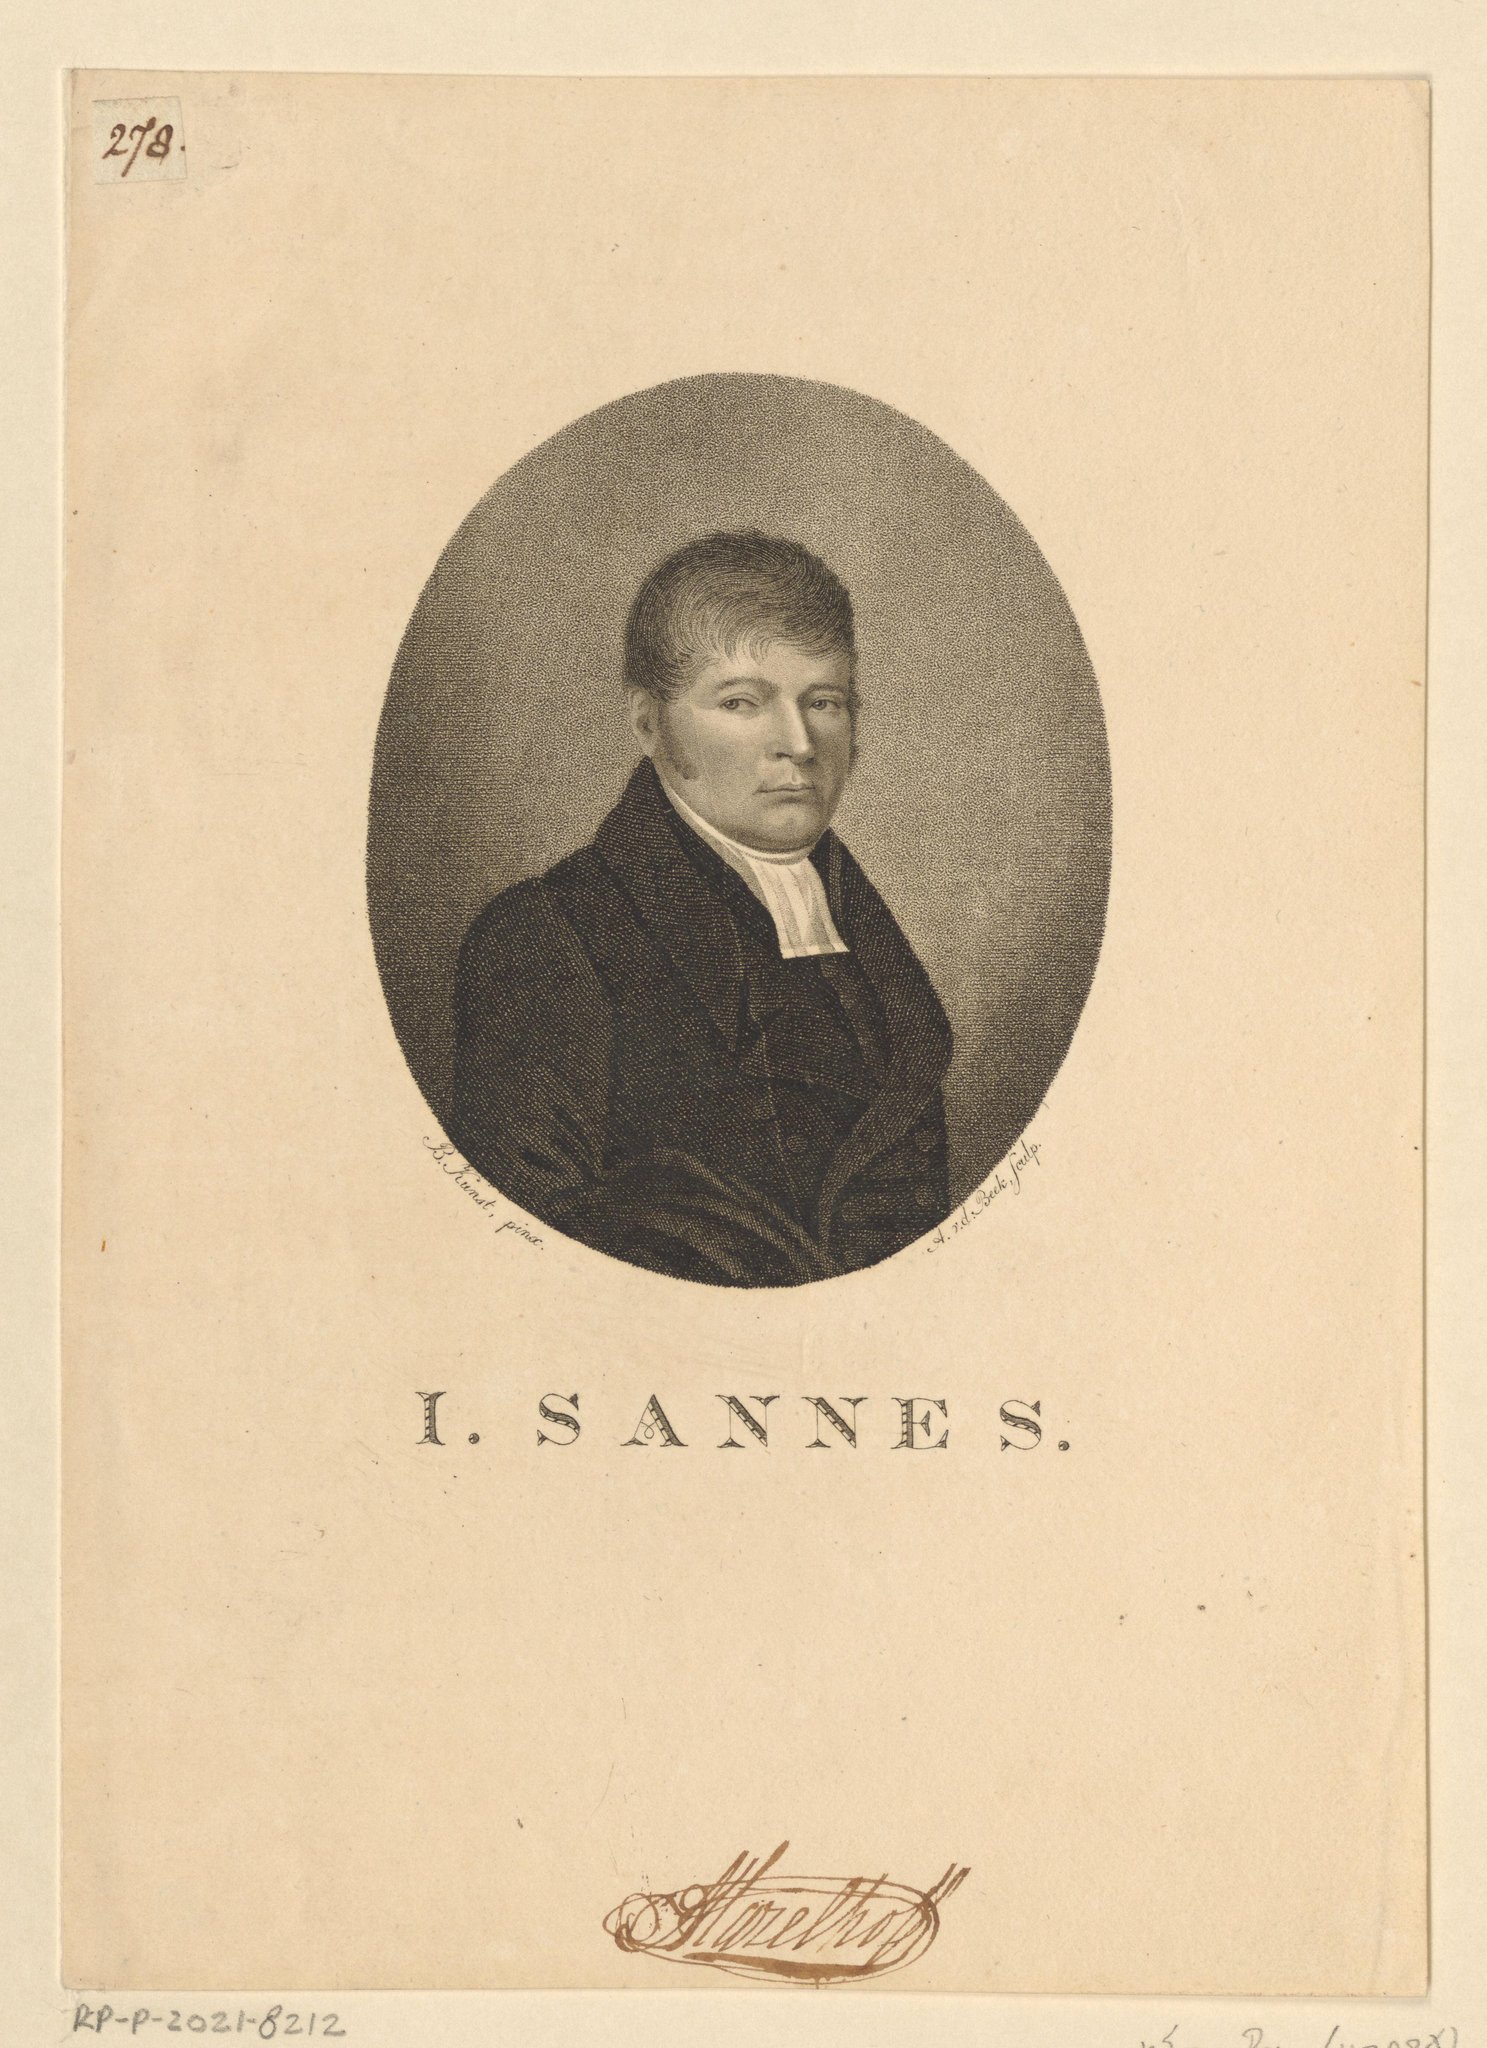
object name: print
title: Portret van Izaak Sannes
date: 1793-1852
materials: paper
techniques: engraving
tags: historical persons, organization, functionaries and dignitaries in churches and in related institutions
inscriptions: signature: ‘[...]hazelhof[...]’, inscription: ‘278’